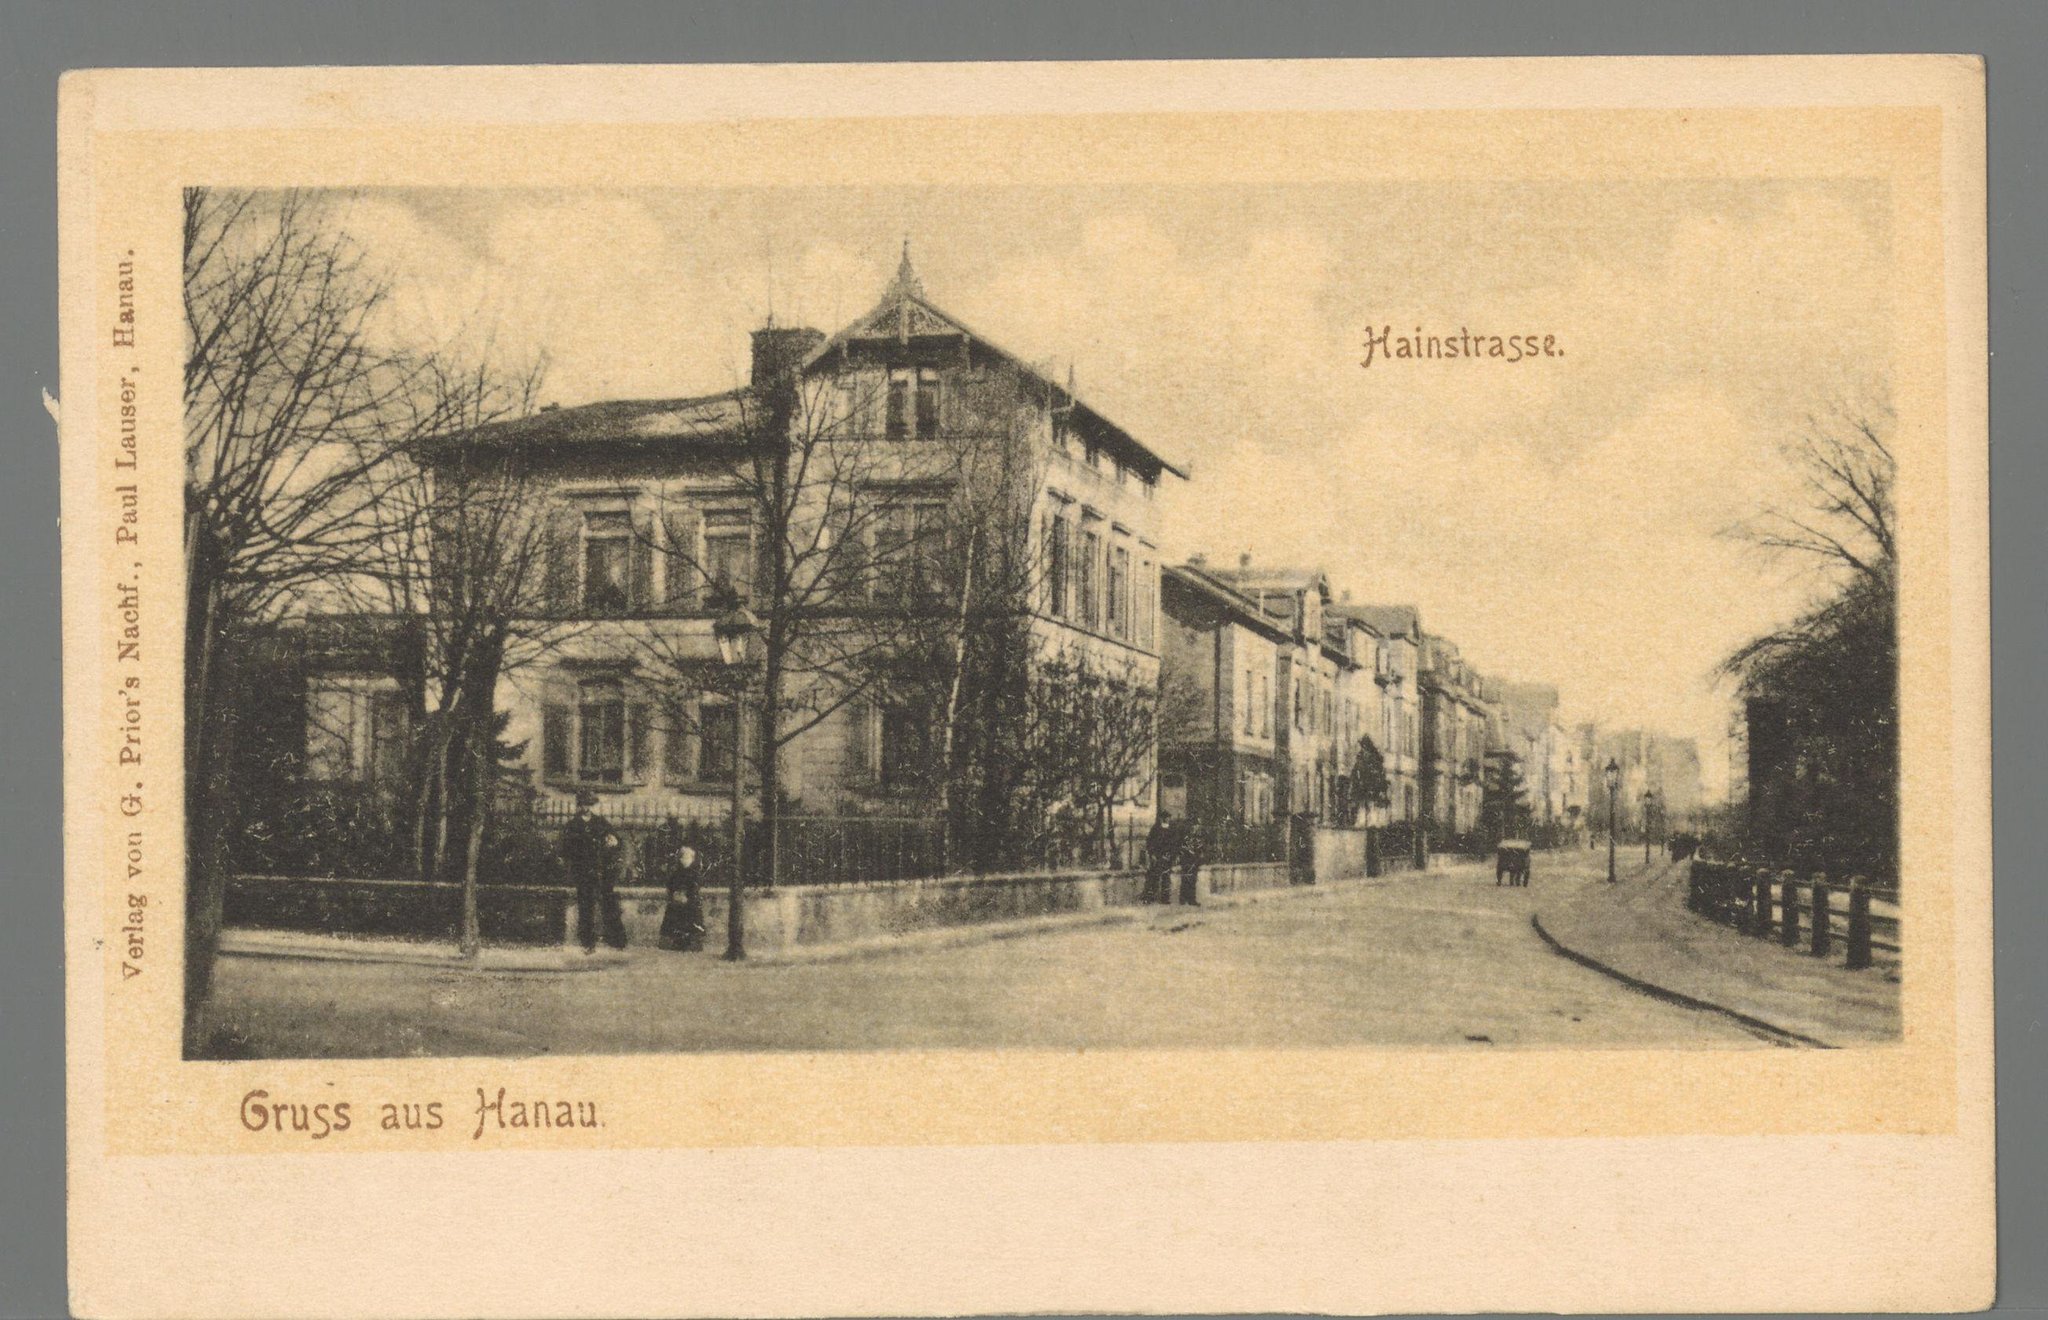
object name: photomechanical print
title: Gruss aus Hanau. Hainstrasse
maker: Anonymous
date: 1885-1905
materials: cardboard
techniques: photograph, lithograph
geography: hanau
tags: street